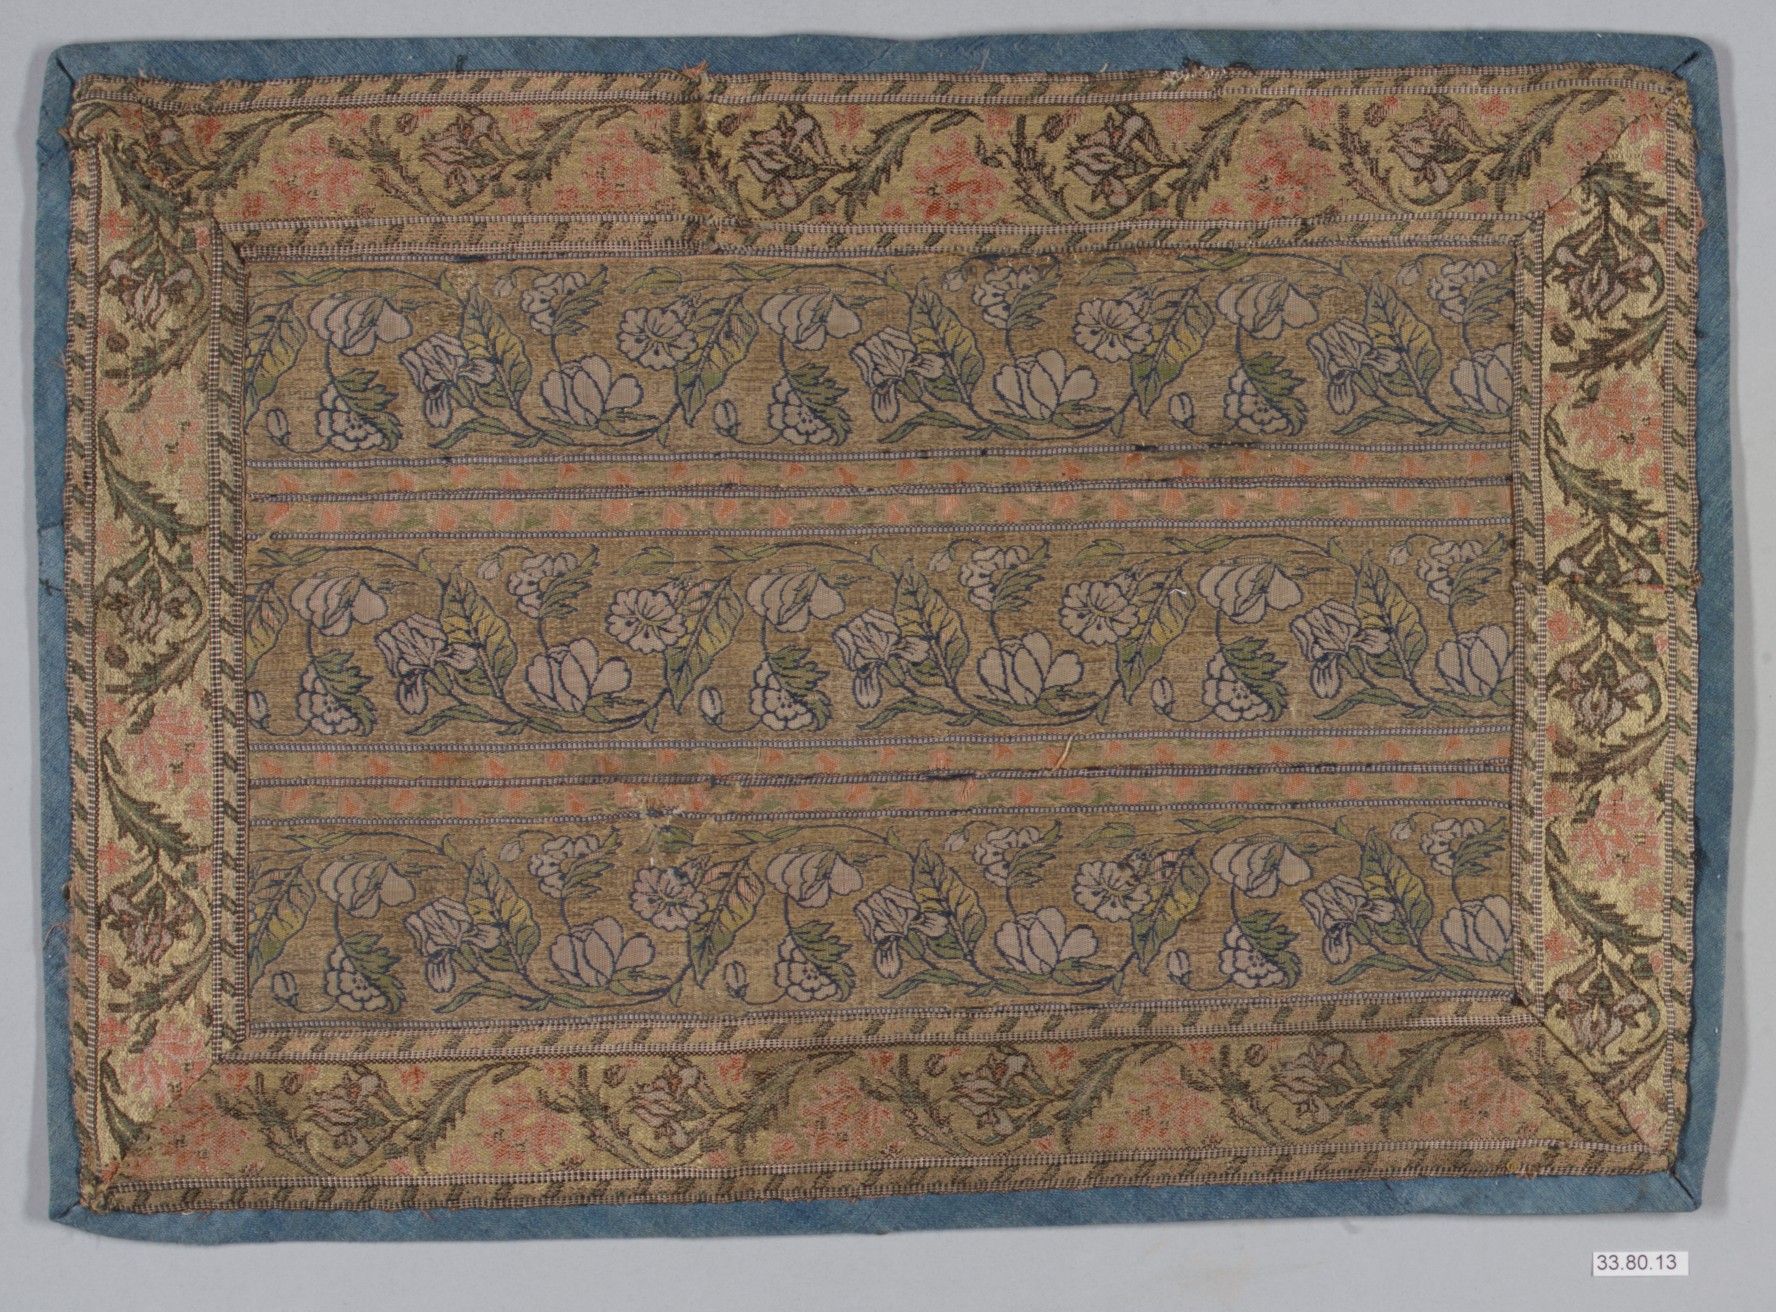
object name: panel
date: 1601-1700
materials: metal thread, silk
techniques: brocade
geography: iran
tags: flowers